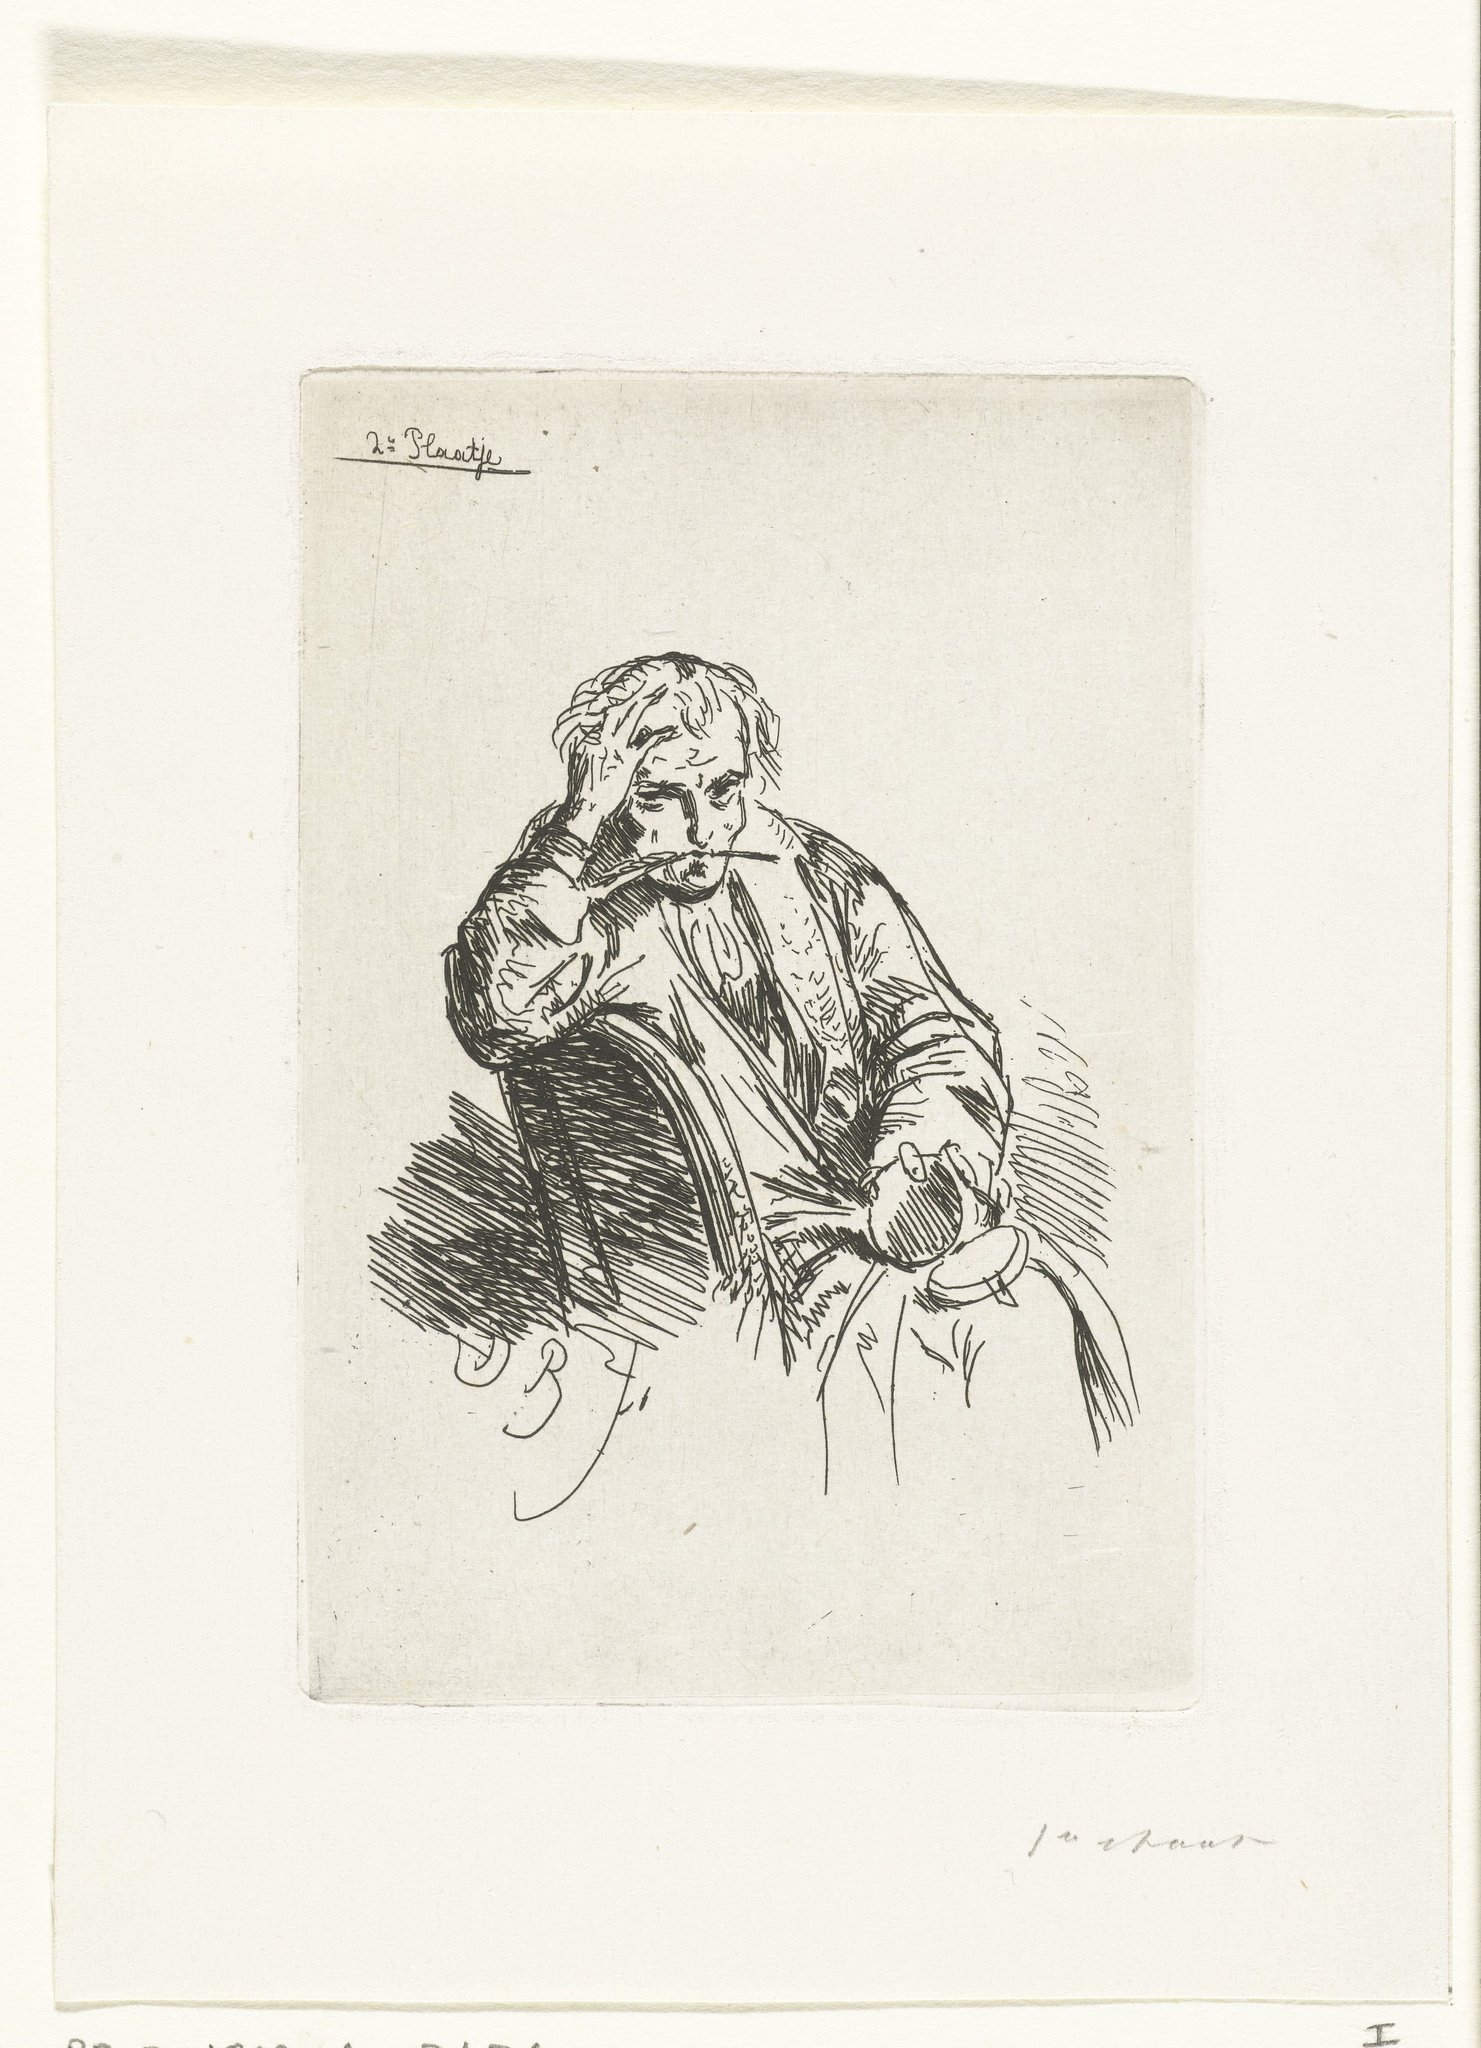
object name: print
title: Schrijver met pen in zijn mond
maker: david bles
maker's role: draughtsman, painter, print maker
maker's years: 1821-1899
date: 1834-1892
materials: paper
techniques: etching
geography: the hague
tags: writer, poet, author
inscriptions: collector's mark: Lugt 2228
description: Een man met een kamerjas aan zit op een stoel met een pen in zijn mond. In zijn hand houdt hij een doosje.